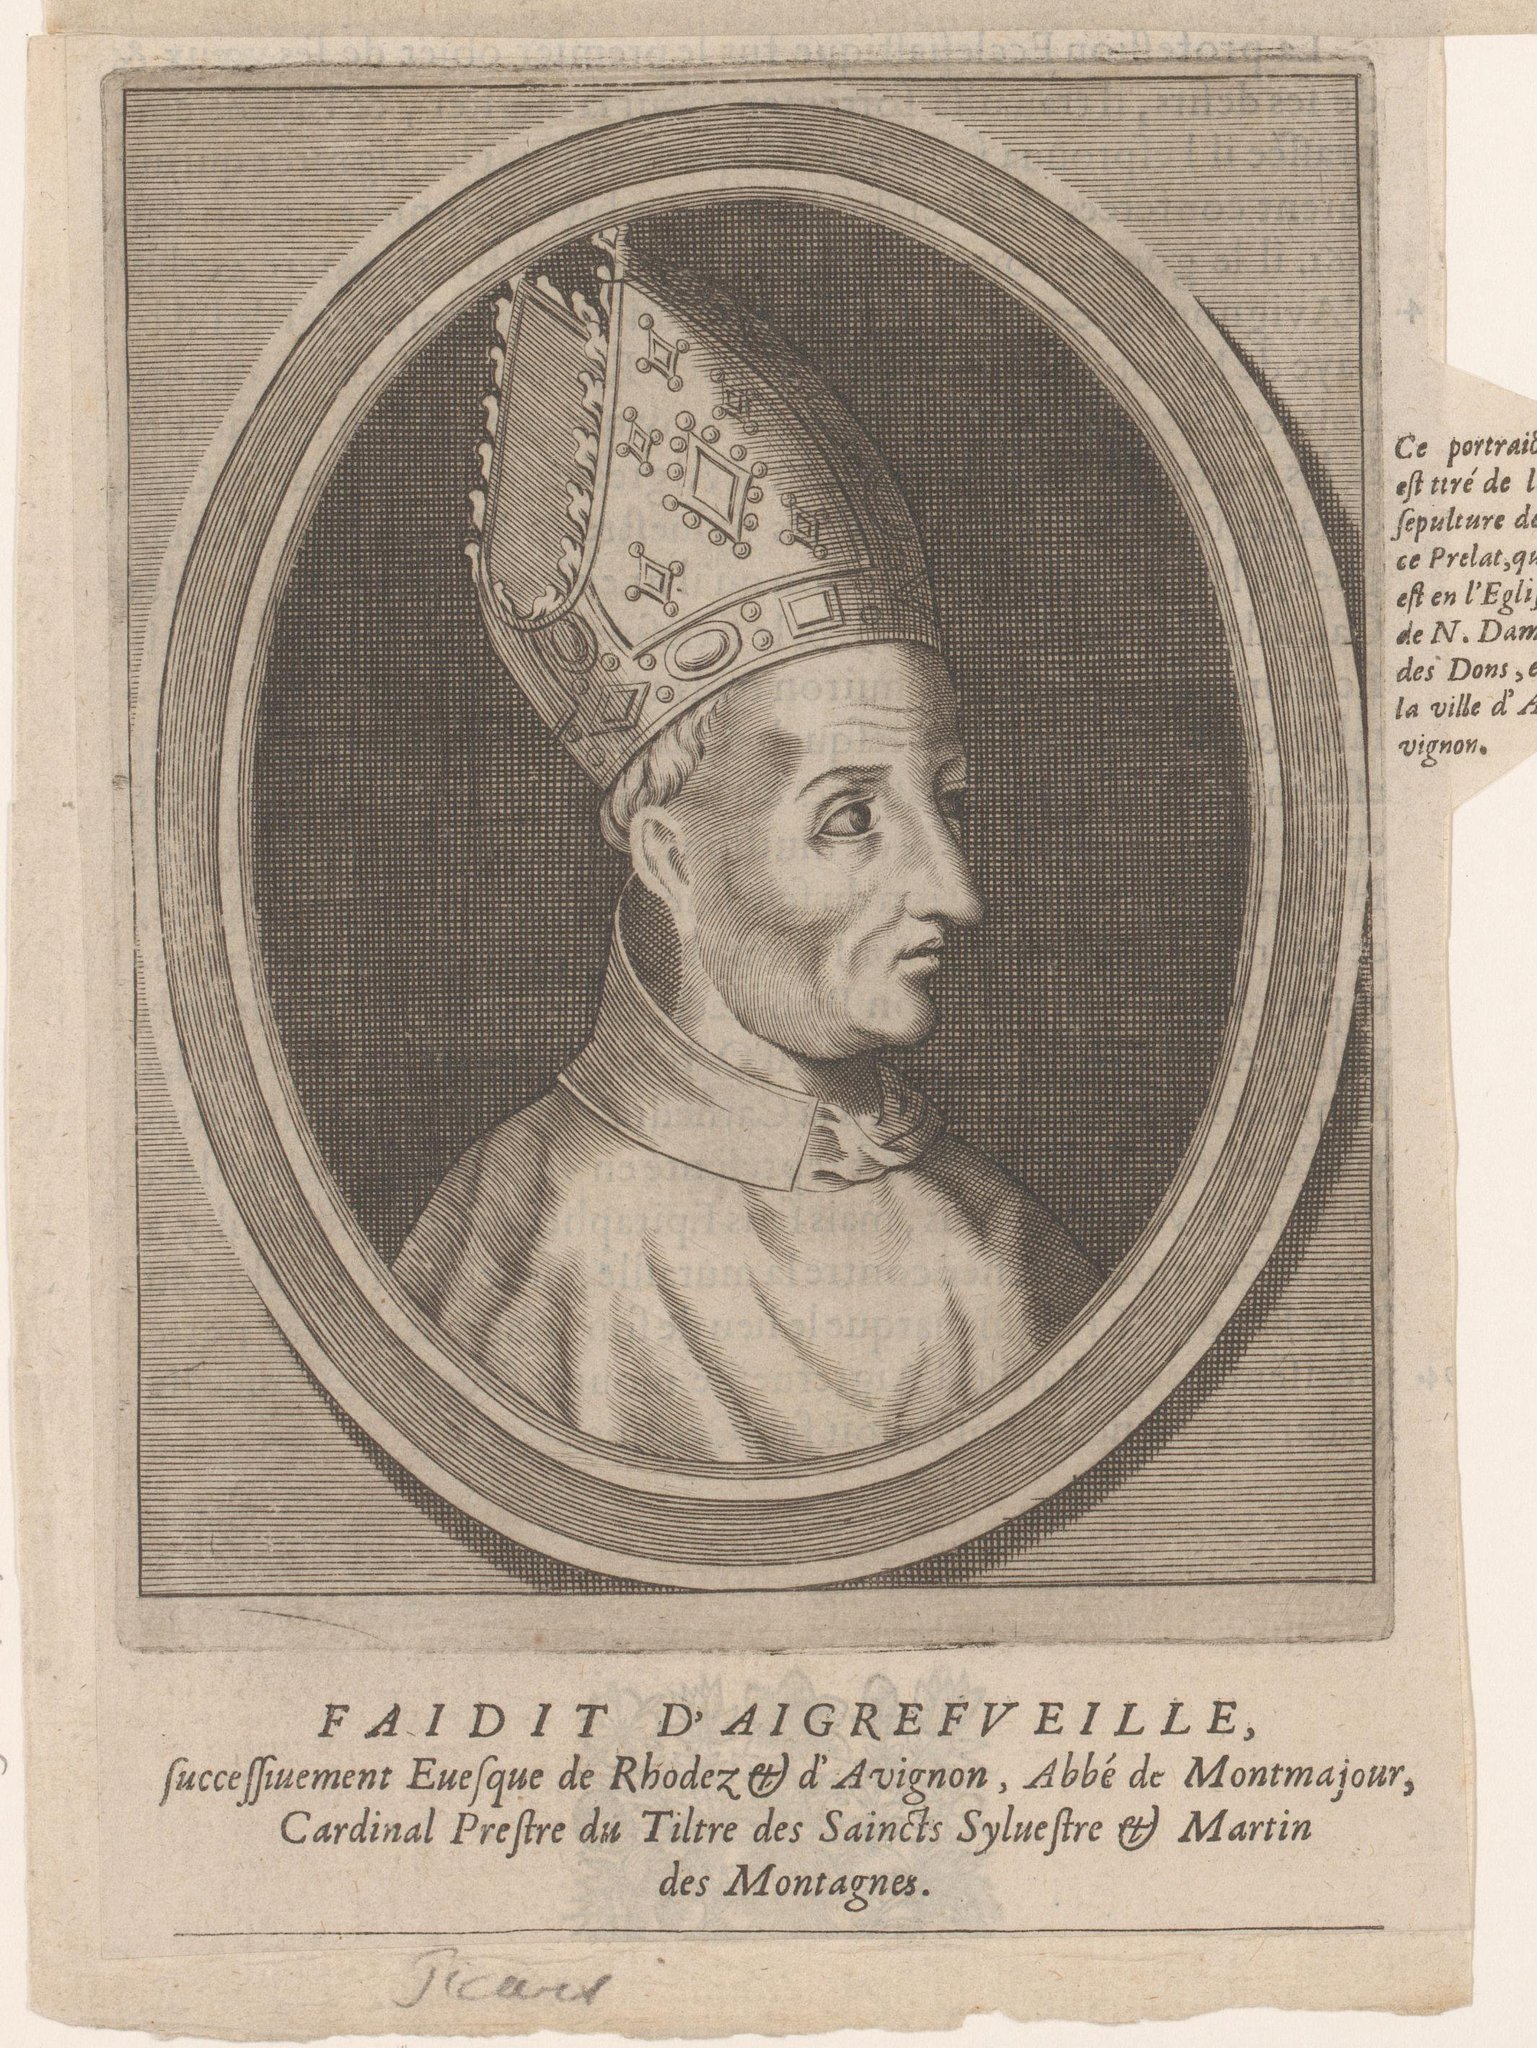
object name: print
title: Faidit D'Aigrefveille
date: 1660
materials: paper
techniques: engraving, etching, letterpress printing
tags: archbishop, bishop, etc. (roman catholic), historical persons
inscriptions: collector's mark: Lugt 2228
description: Prent uit: Du Chesne, François. Histoire de tous les cardinaux françois de naissance, ou qui ont esté promeus au cardinalat. Parijs: François Du Chesne, 1660.